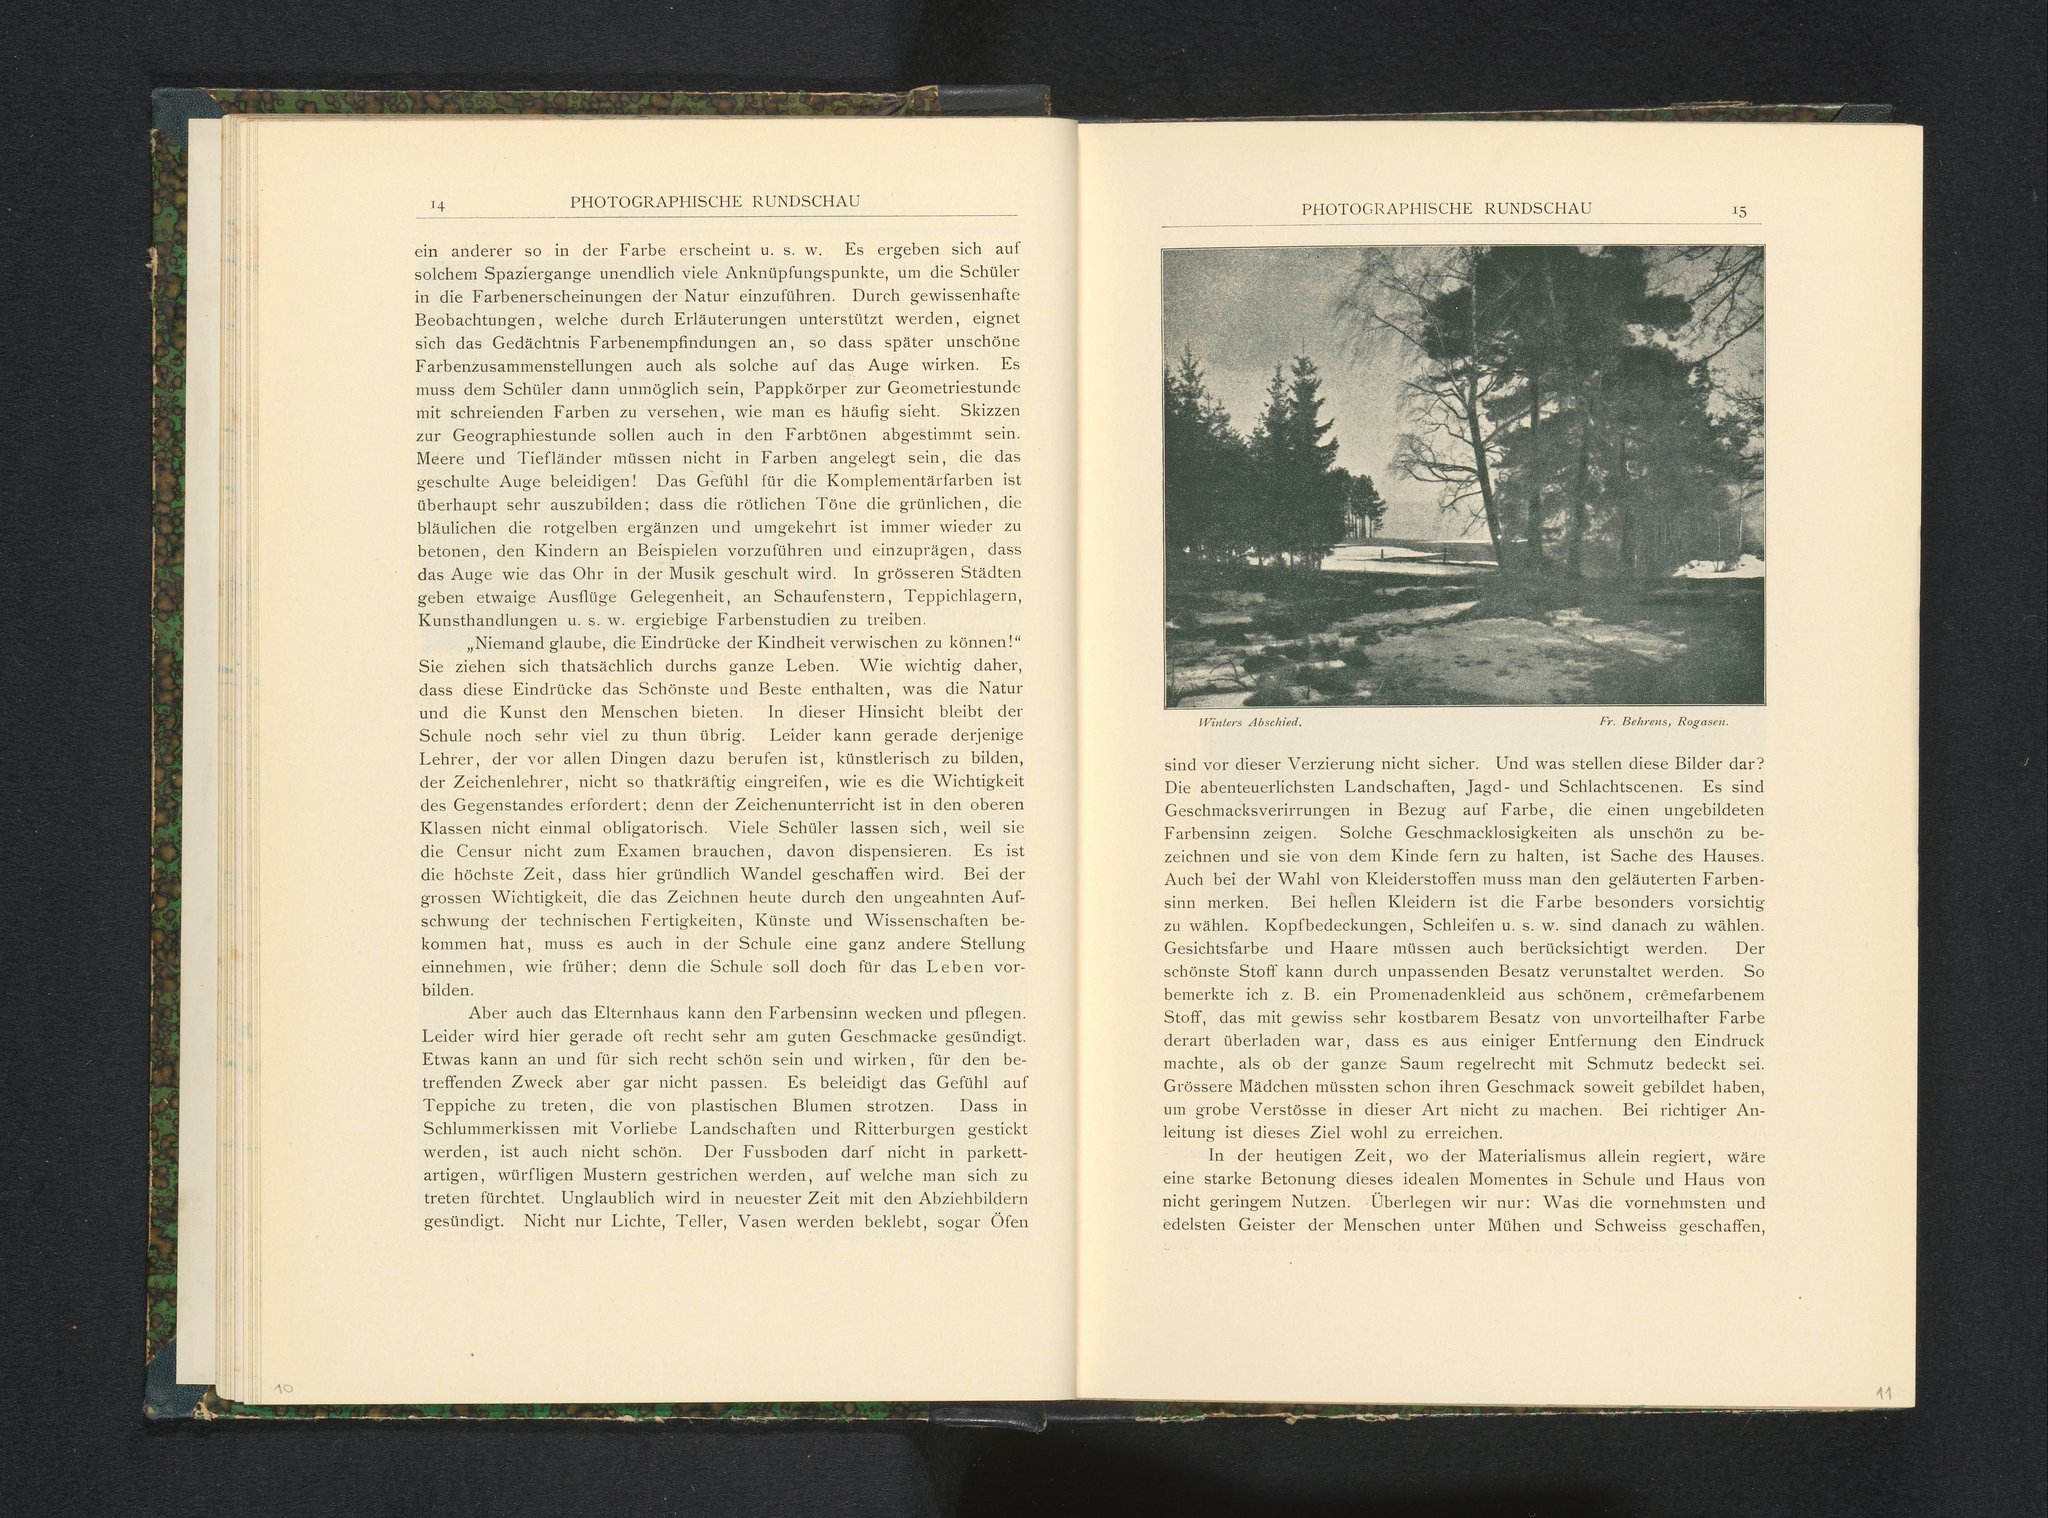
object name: page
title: Gezicht op een winters landschap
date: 1894-1899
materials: paper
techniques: autotype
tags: landscapes, snow